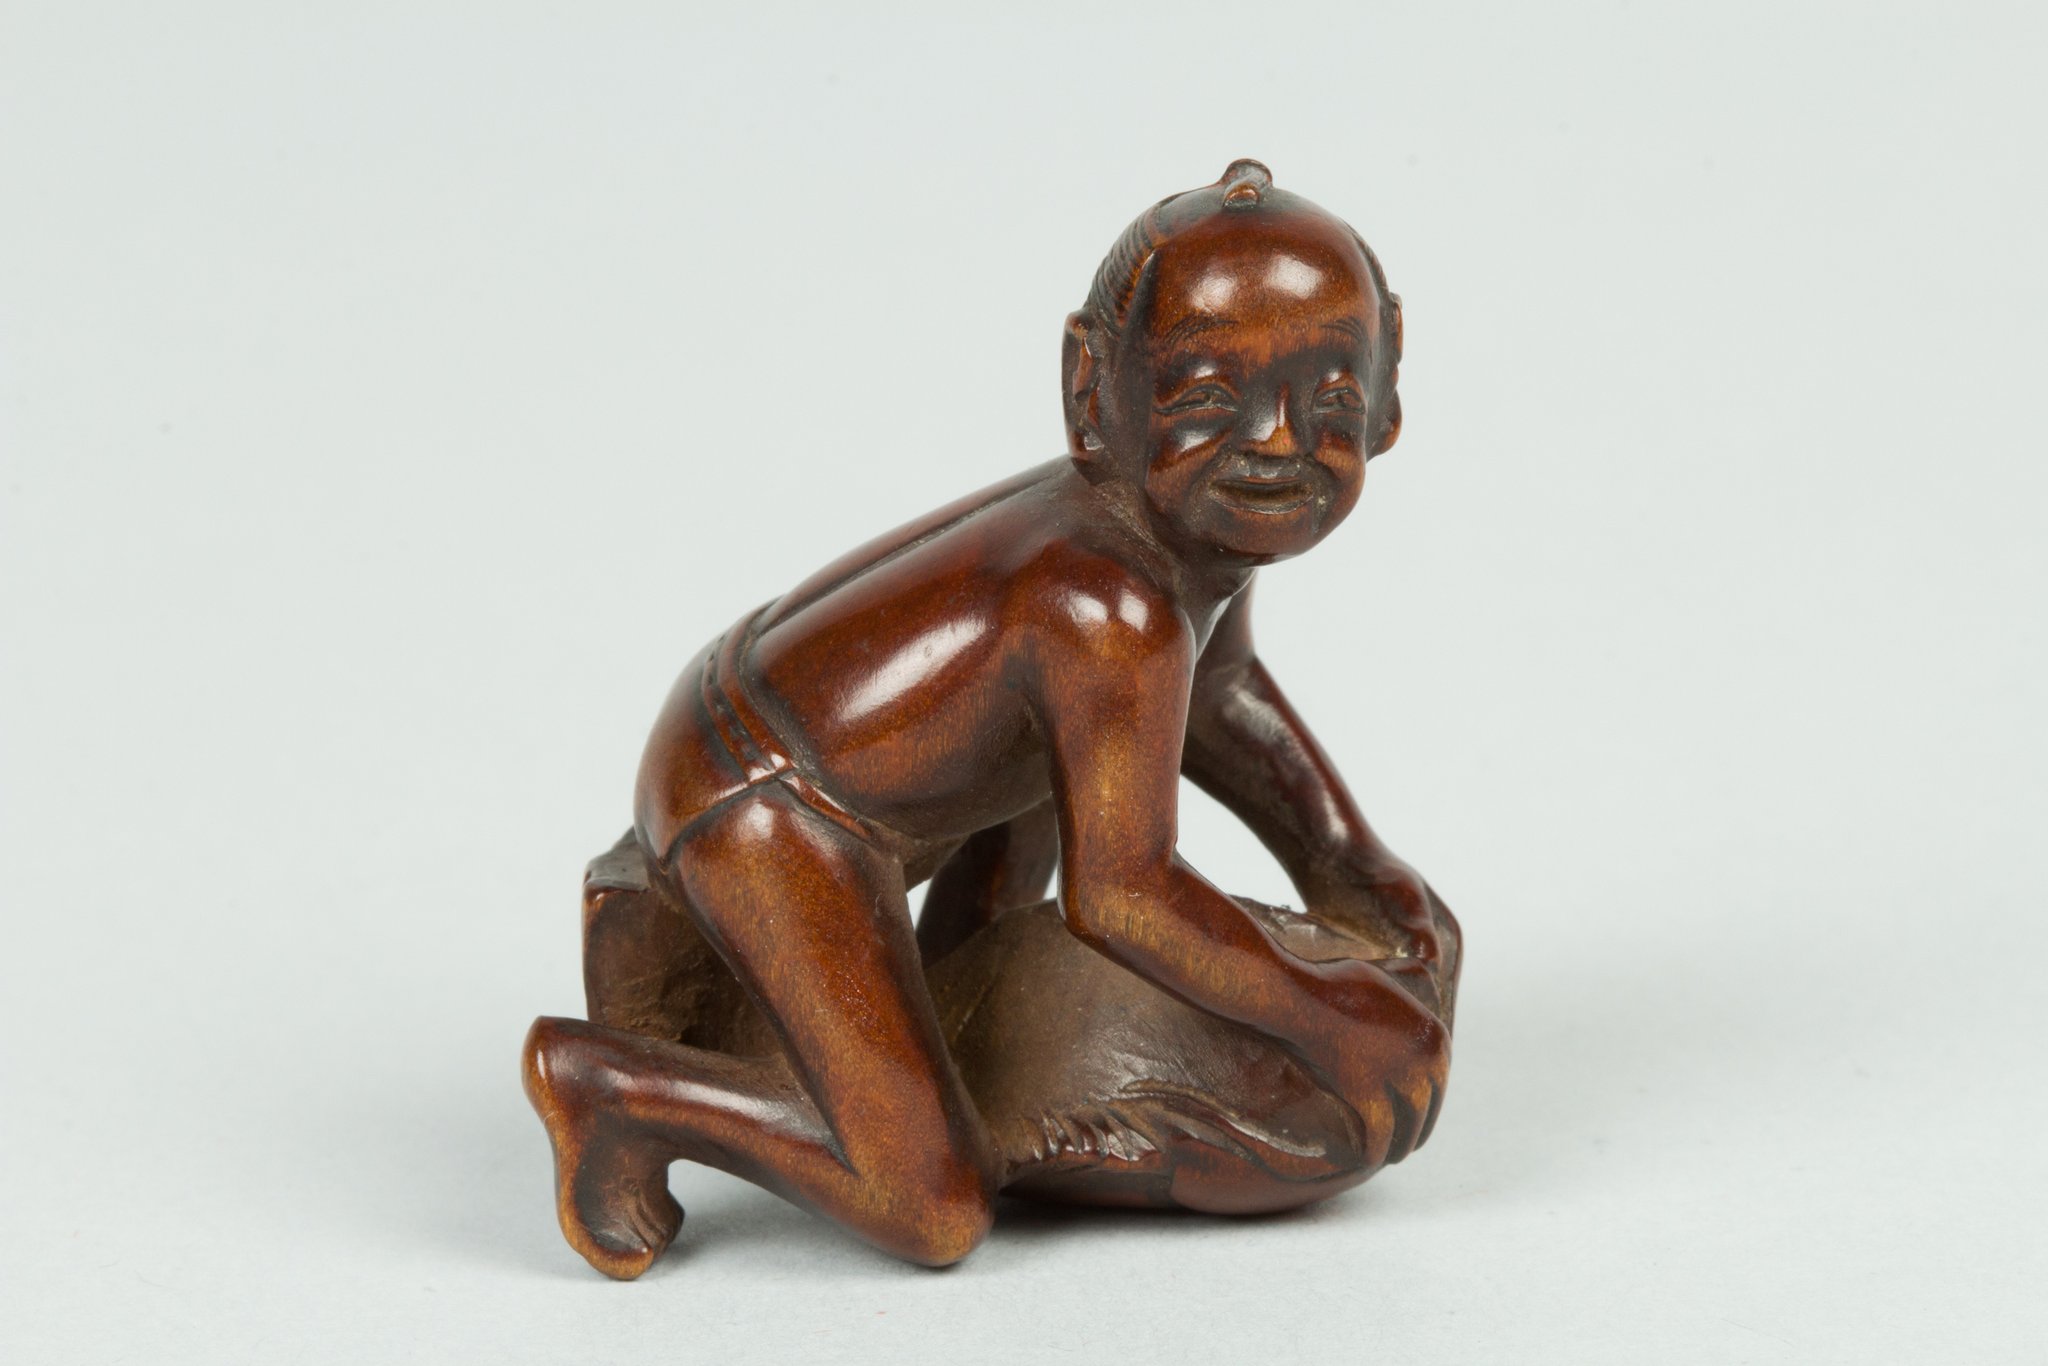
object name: netsuke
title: Netsuke of Boy on a Carp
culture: japanese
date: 1801-1900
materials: wood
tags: boys